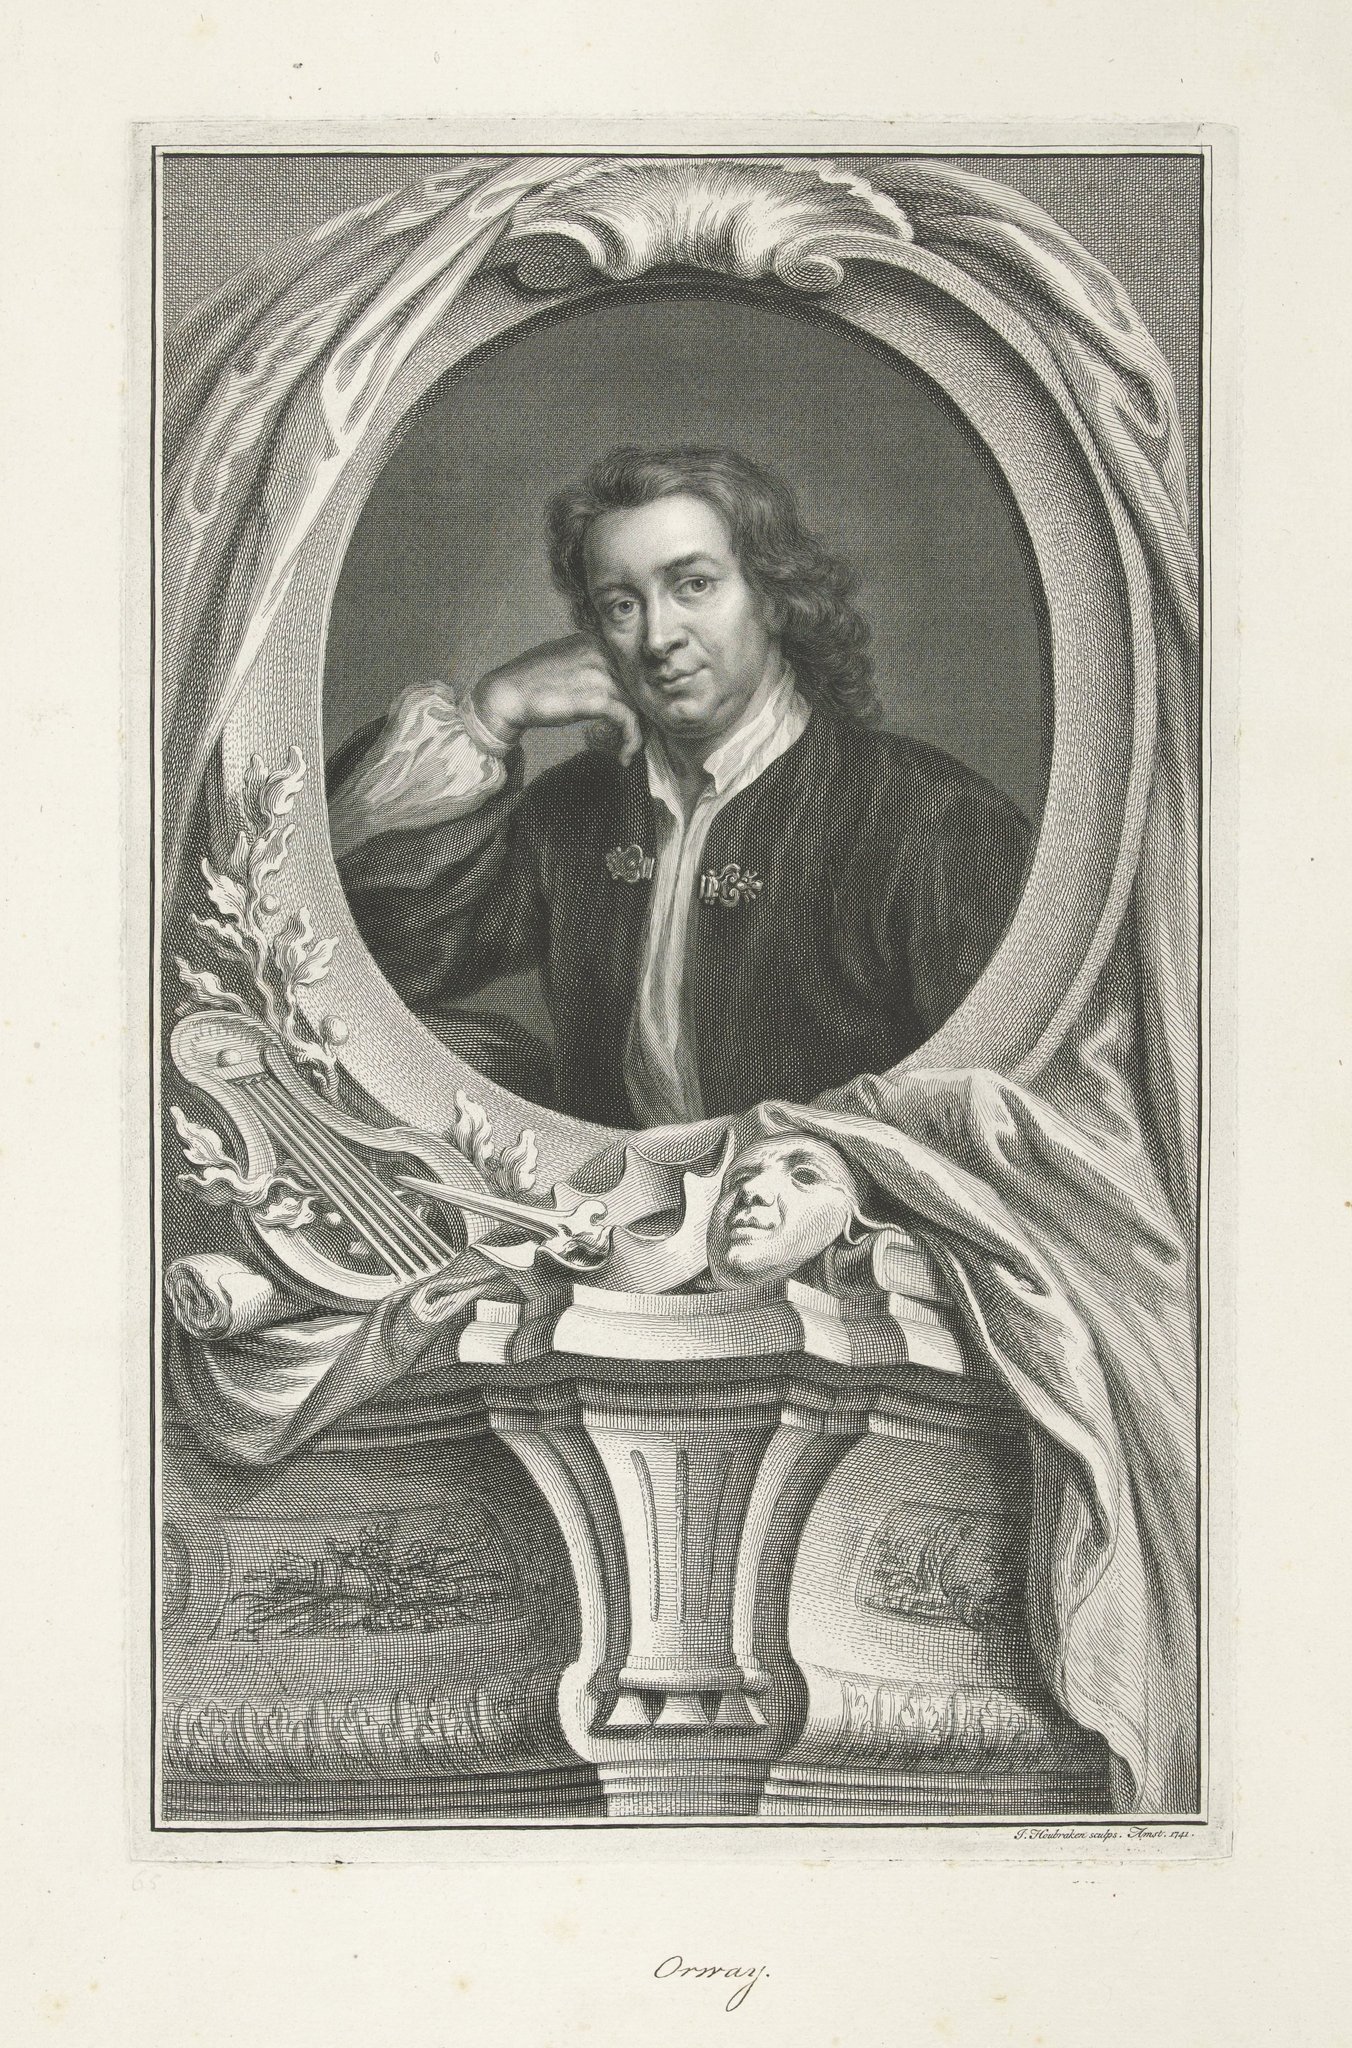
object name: print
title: Portret van Thomas Otway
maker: jacob houbraken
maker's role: draughtsman, print maker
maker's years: 1698-1780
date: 1741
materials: paper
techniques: engraving, etching, pen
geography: amsterdam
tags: toneelschrijver, thomas otway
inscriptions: collector's mark: Lugt 240, name: ‘Orway’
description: Prent ook gebruikt in: Thomas Birch. The heads of illustrious persons of Great Britain : engraved by Houbraken, and Vertue, with their lives and characters. London: John en Paul Knapton, 1743-1751.